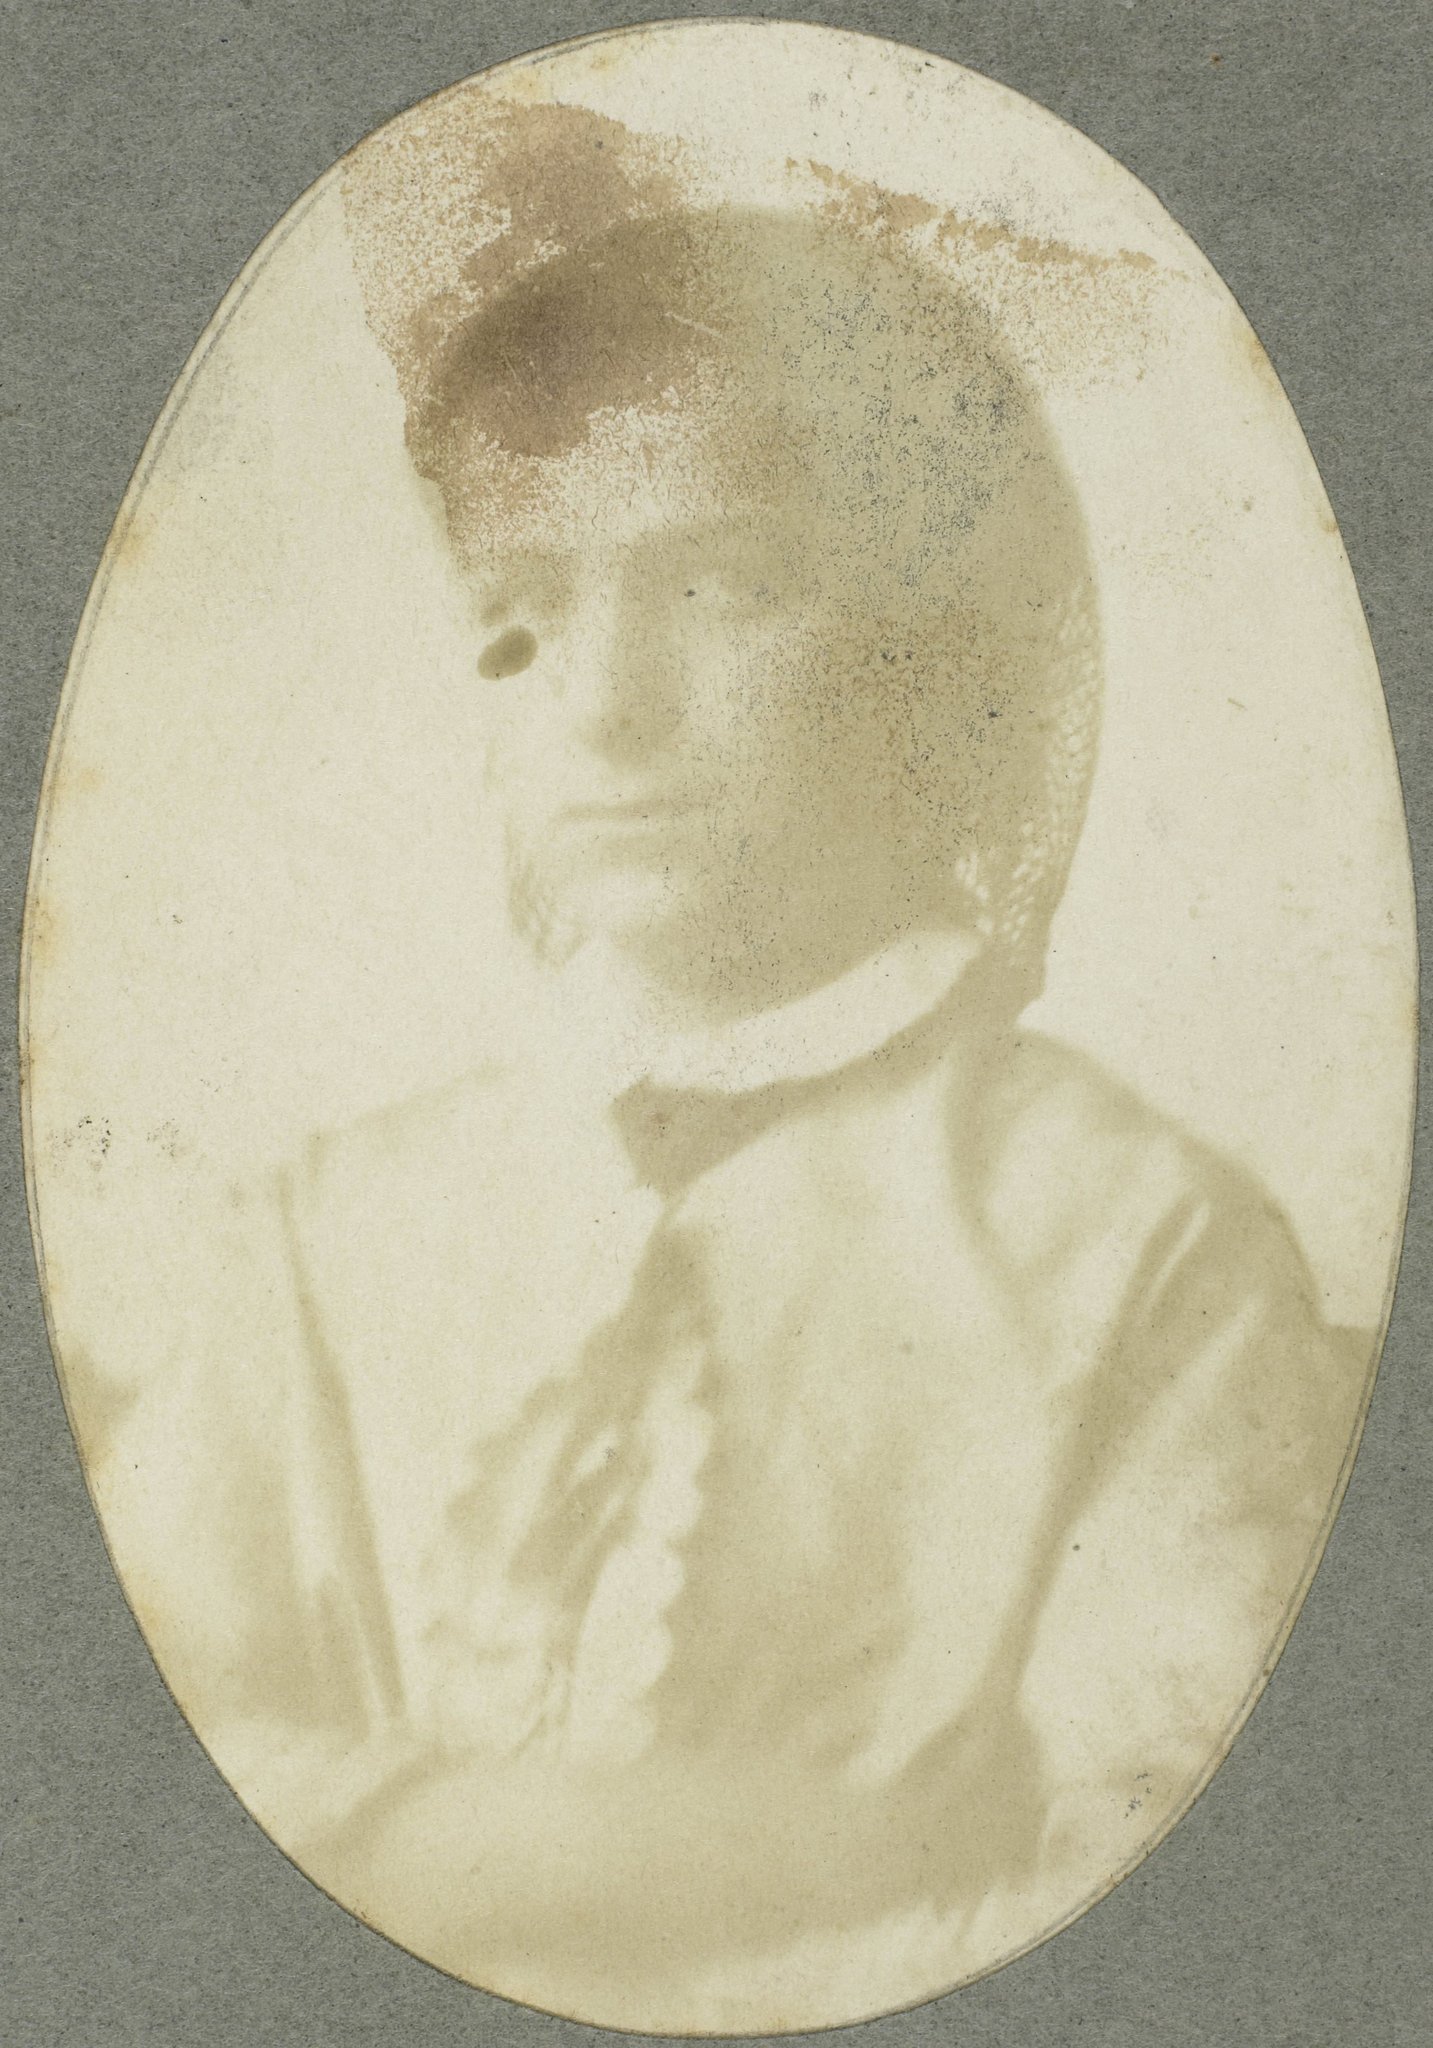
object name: photograph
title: Portret van een jonge vrouw met haarnetje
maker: eduard isaac asser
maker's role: amateurfotograaf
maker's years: 1809-1894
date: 1852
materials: cardboard, paper, photographic support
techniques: salted paper print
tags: netherlands